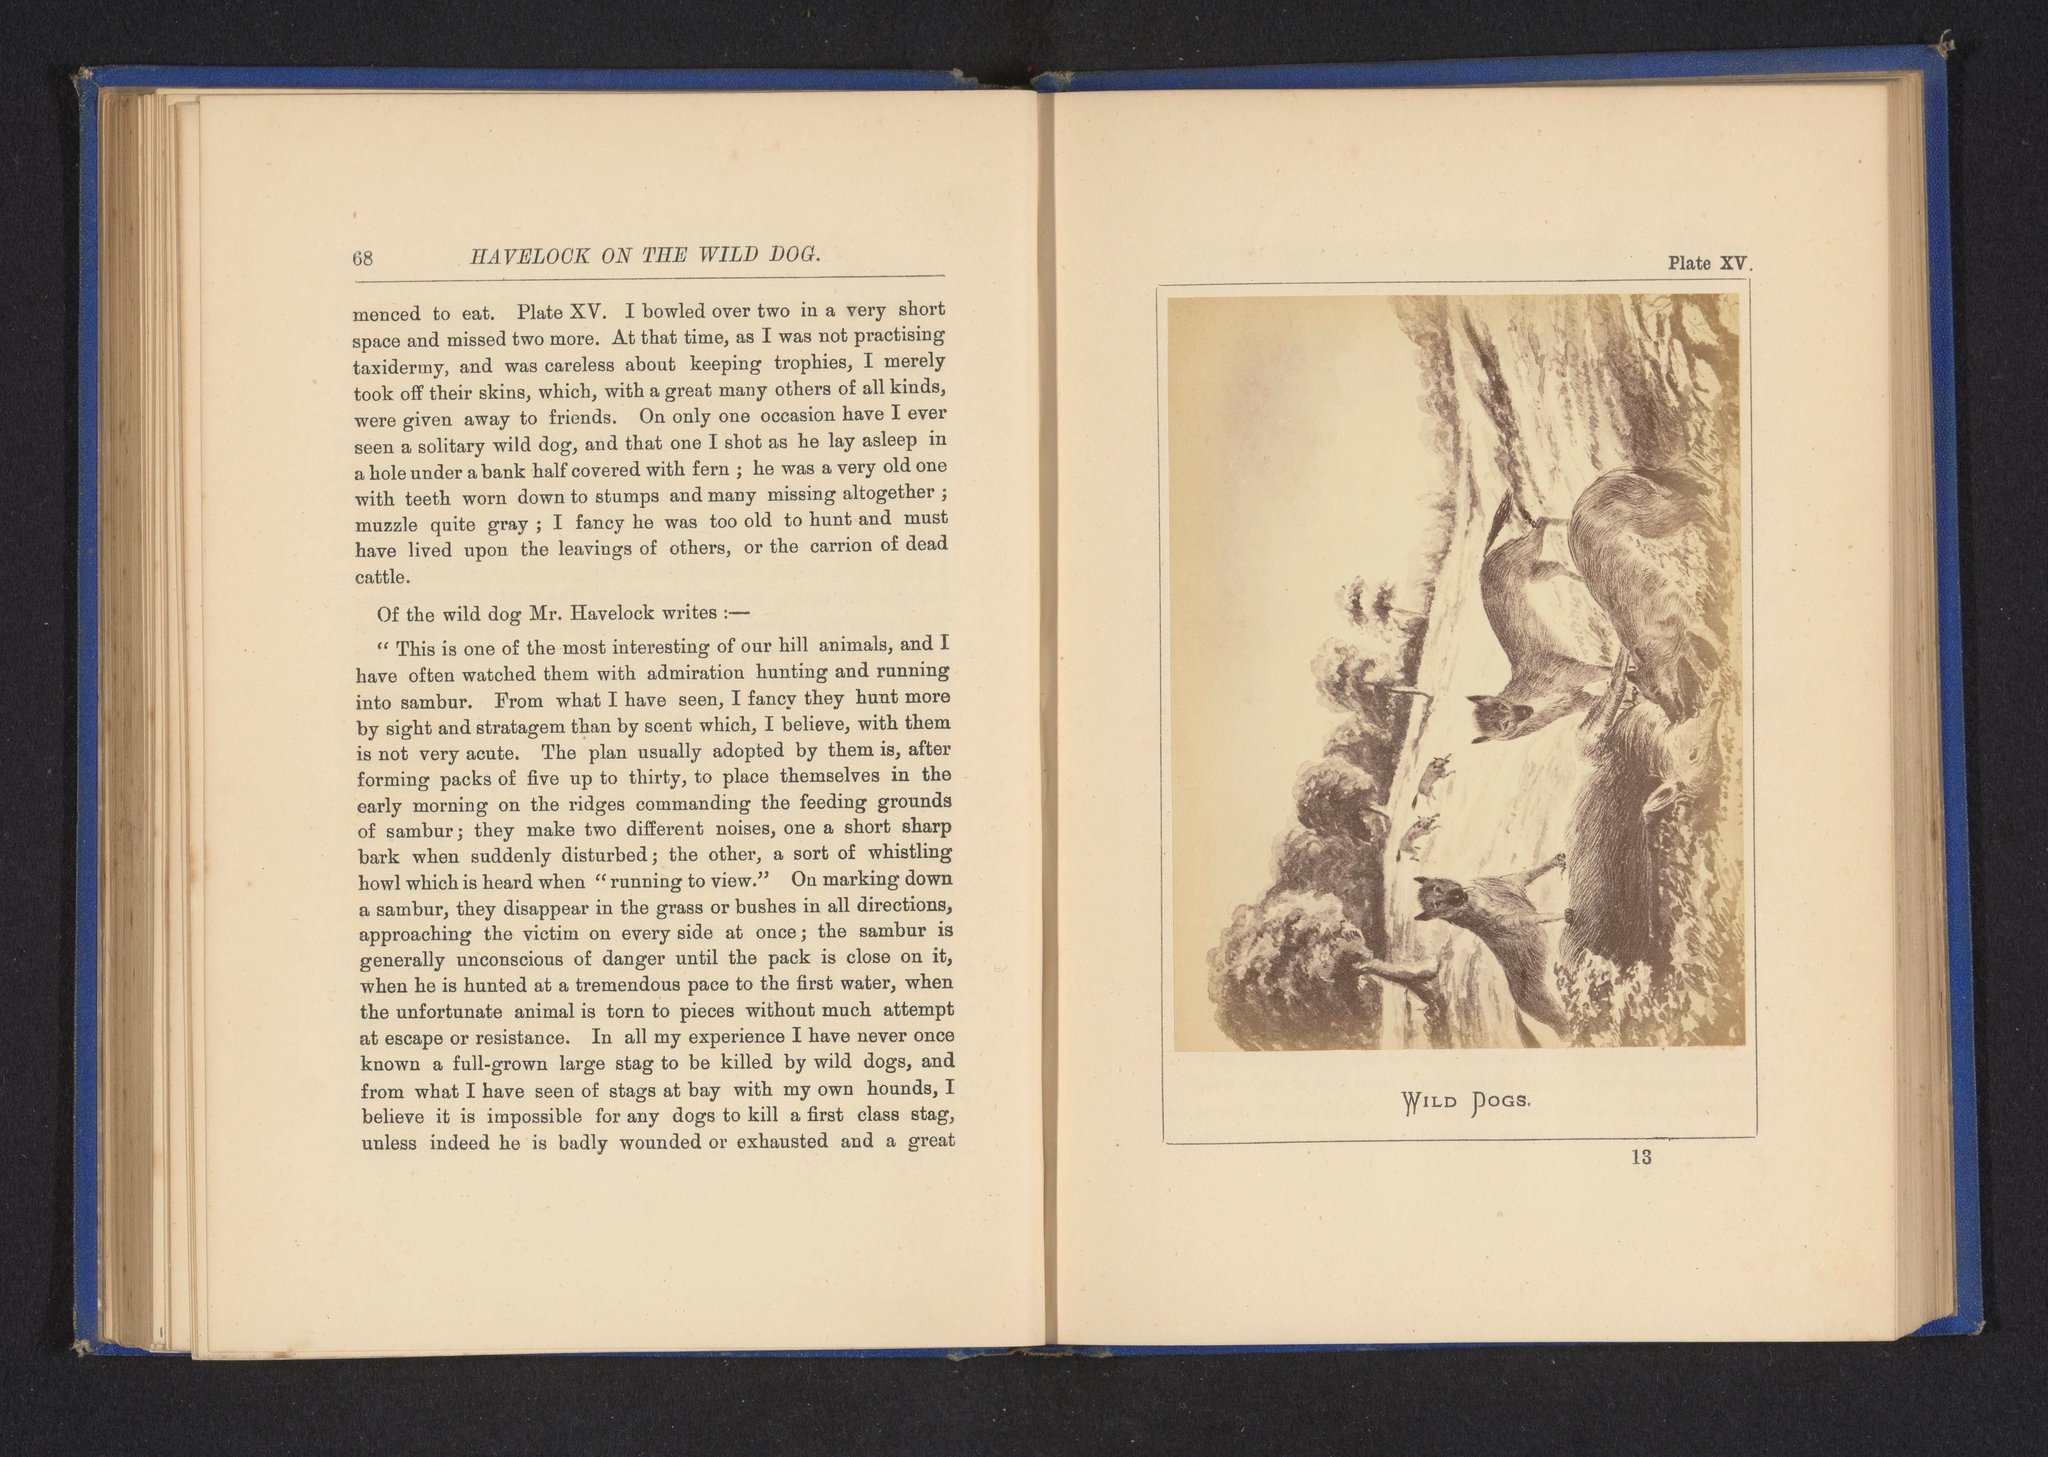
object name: photograph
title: Fotoreproductie van een tekening van een groep wilde honden die een hert opeten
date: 1870-1880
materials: photographic support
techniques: albumen print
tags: drawing, sketch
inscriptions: number: ‘Plate XV.’